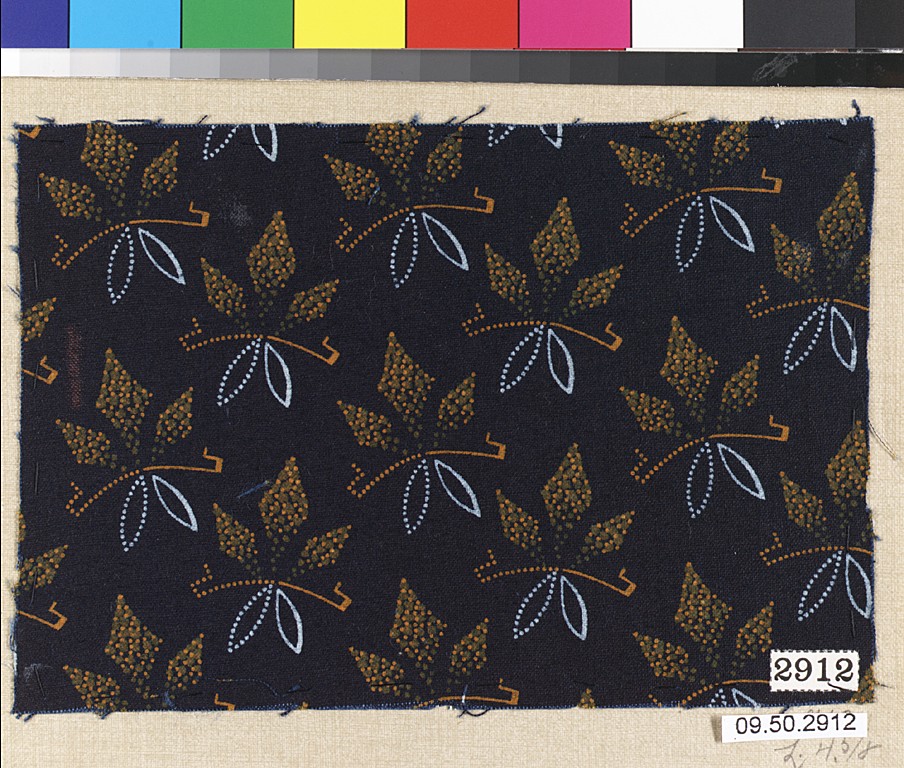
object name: piece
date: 1801-1900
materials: cotton